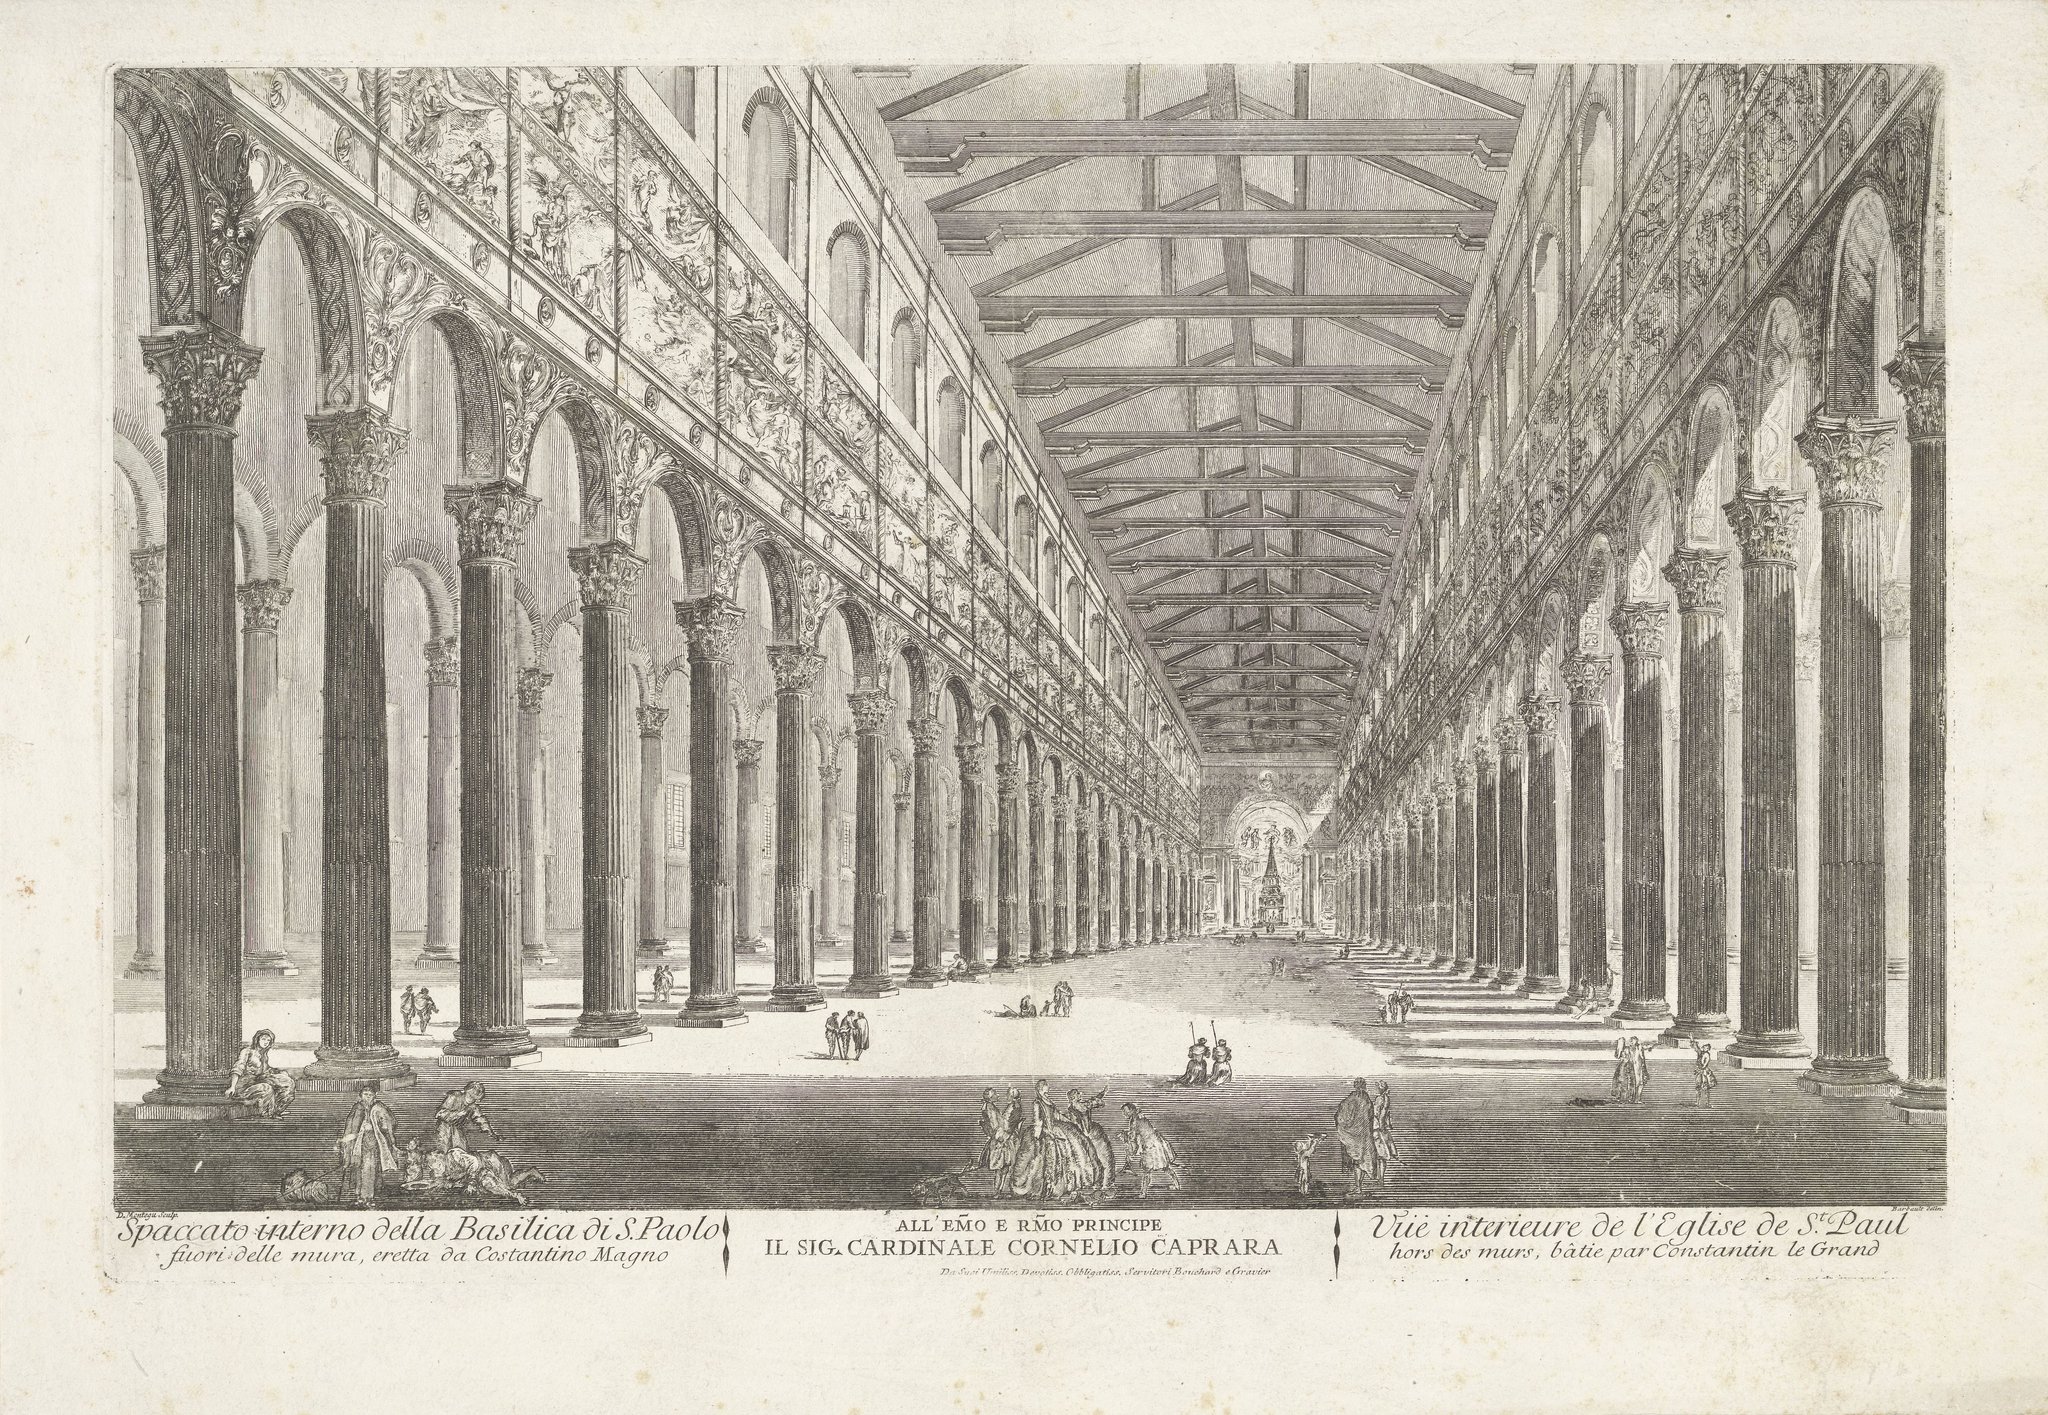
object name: print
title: Spaccato interno della Basilica di S. Paulo / Vue interieure de l'Eglise de St. Paul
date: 1750-1799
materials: paper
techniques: etching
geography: italy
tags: interior of church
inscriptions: collector's mark: Lugt 2228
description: Gezicht in de S. Paolo fuori le Mura te Rome. Titels en tekst in het Frans en Italiaans en een opdracht in de ondermarge.